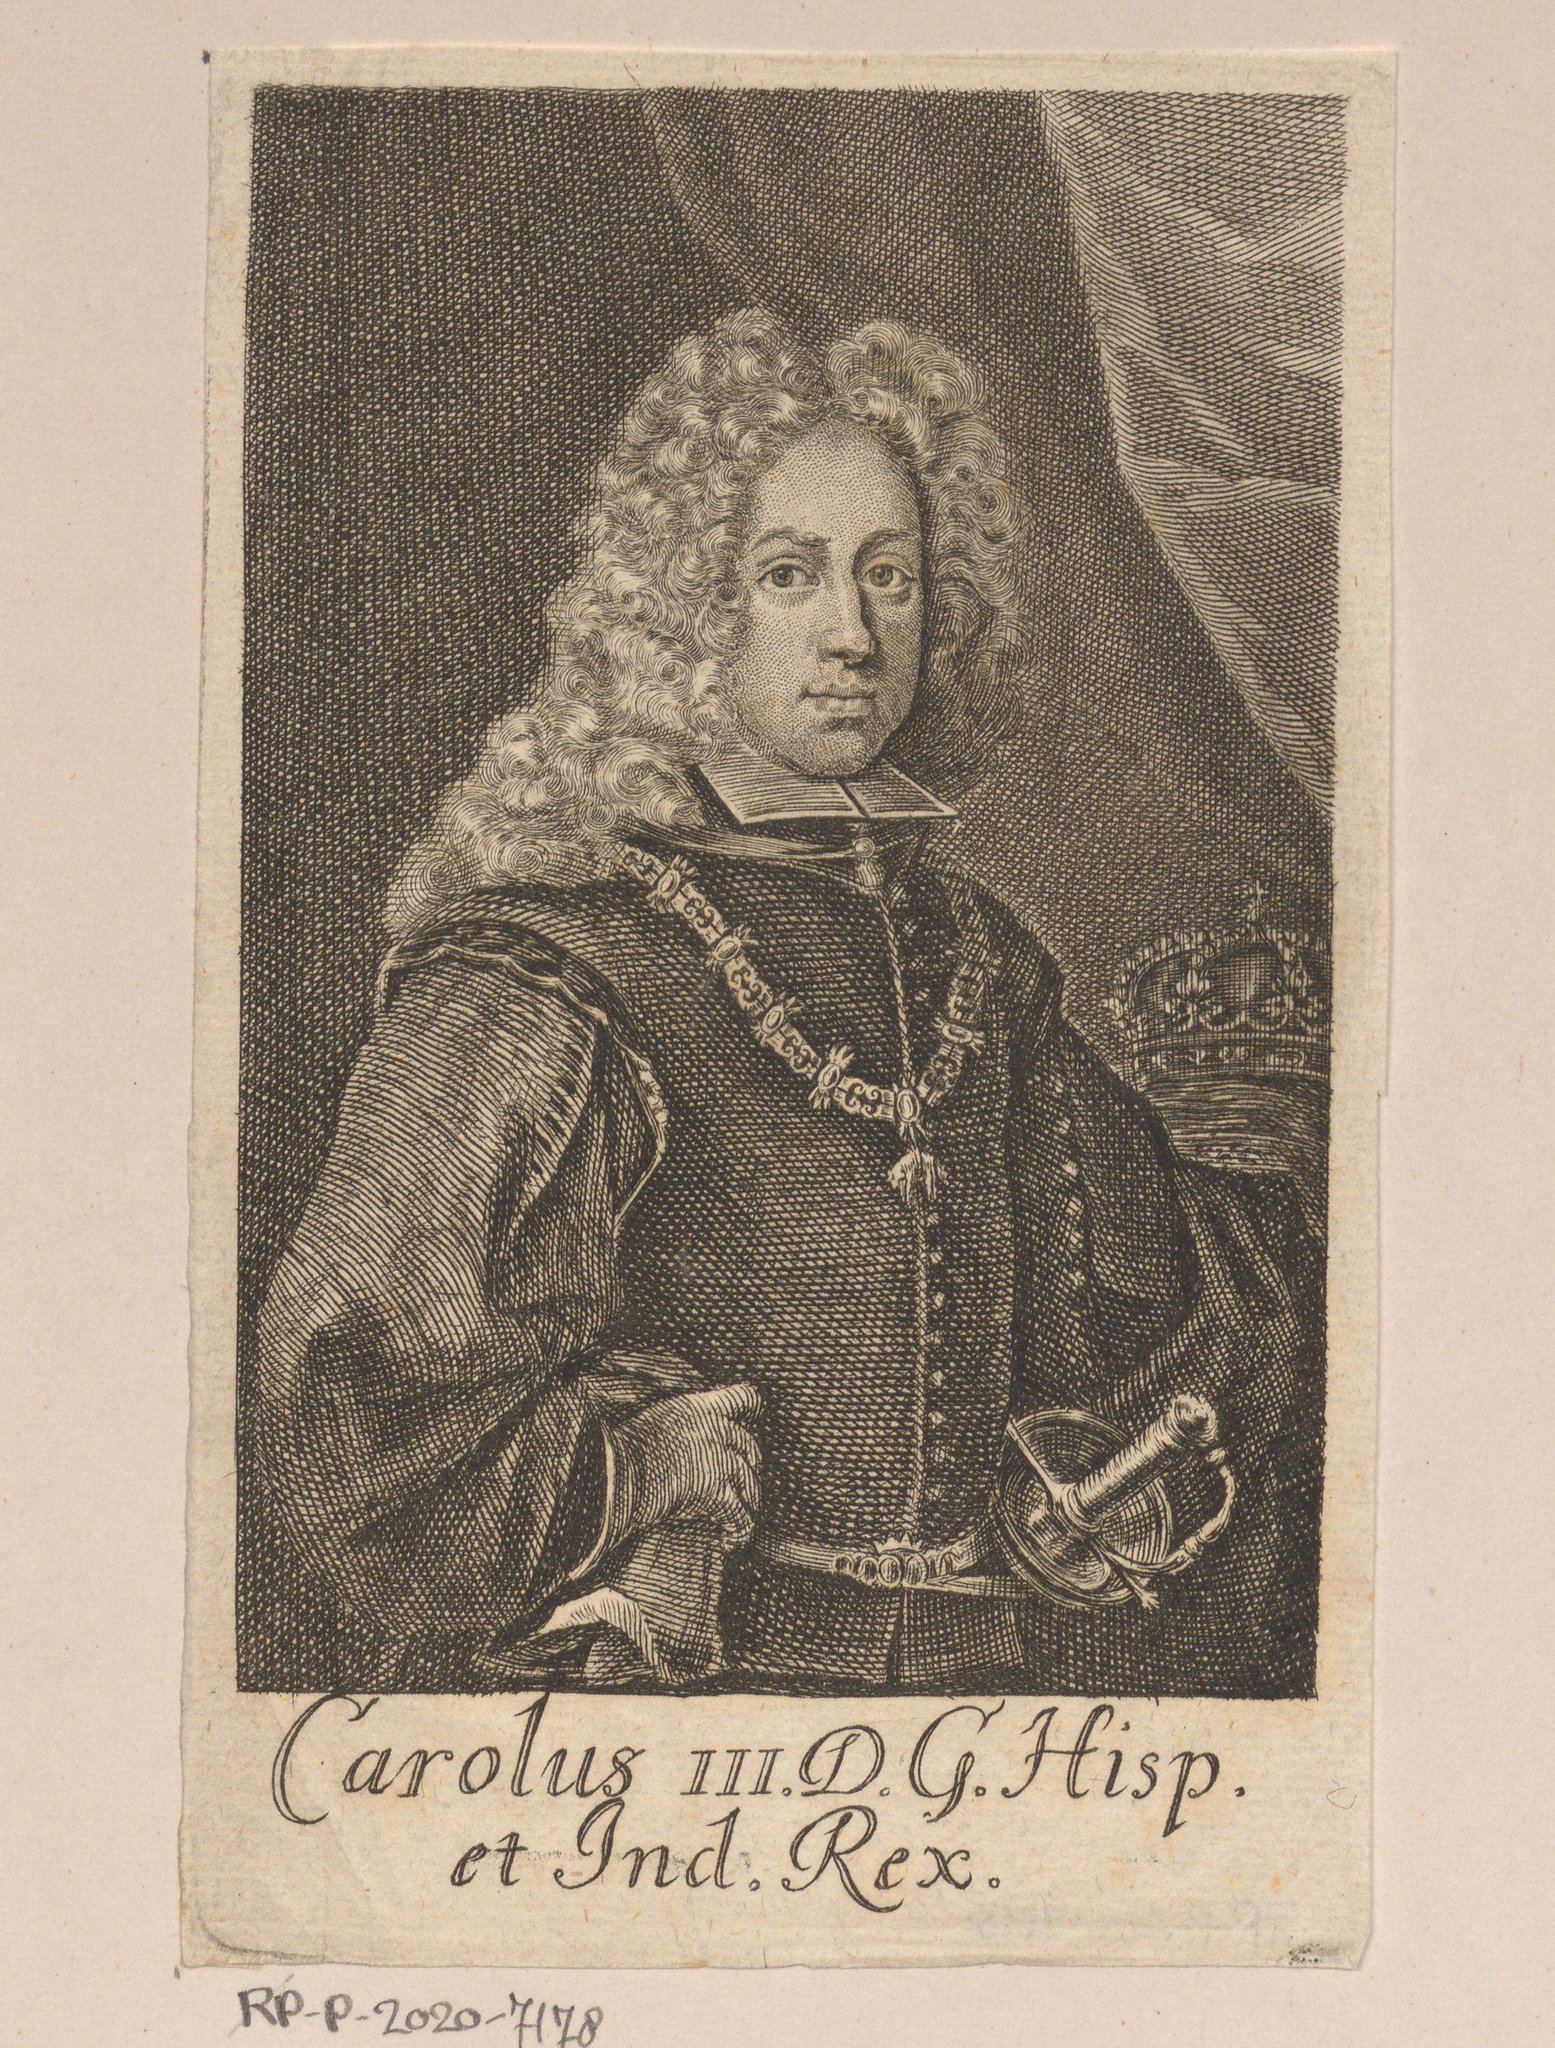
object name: print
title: Portret van keizer Karel VI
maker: Anonymous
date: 1701-1711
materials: paper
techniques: engraving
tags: vienna, charles vi (holy roman emperor), historical persons, knighthood order of the golden fleece, emperor